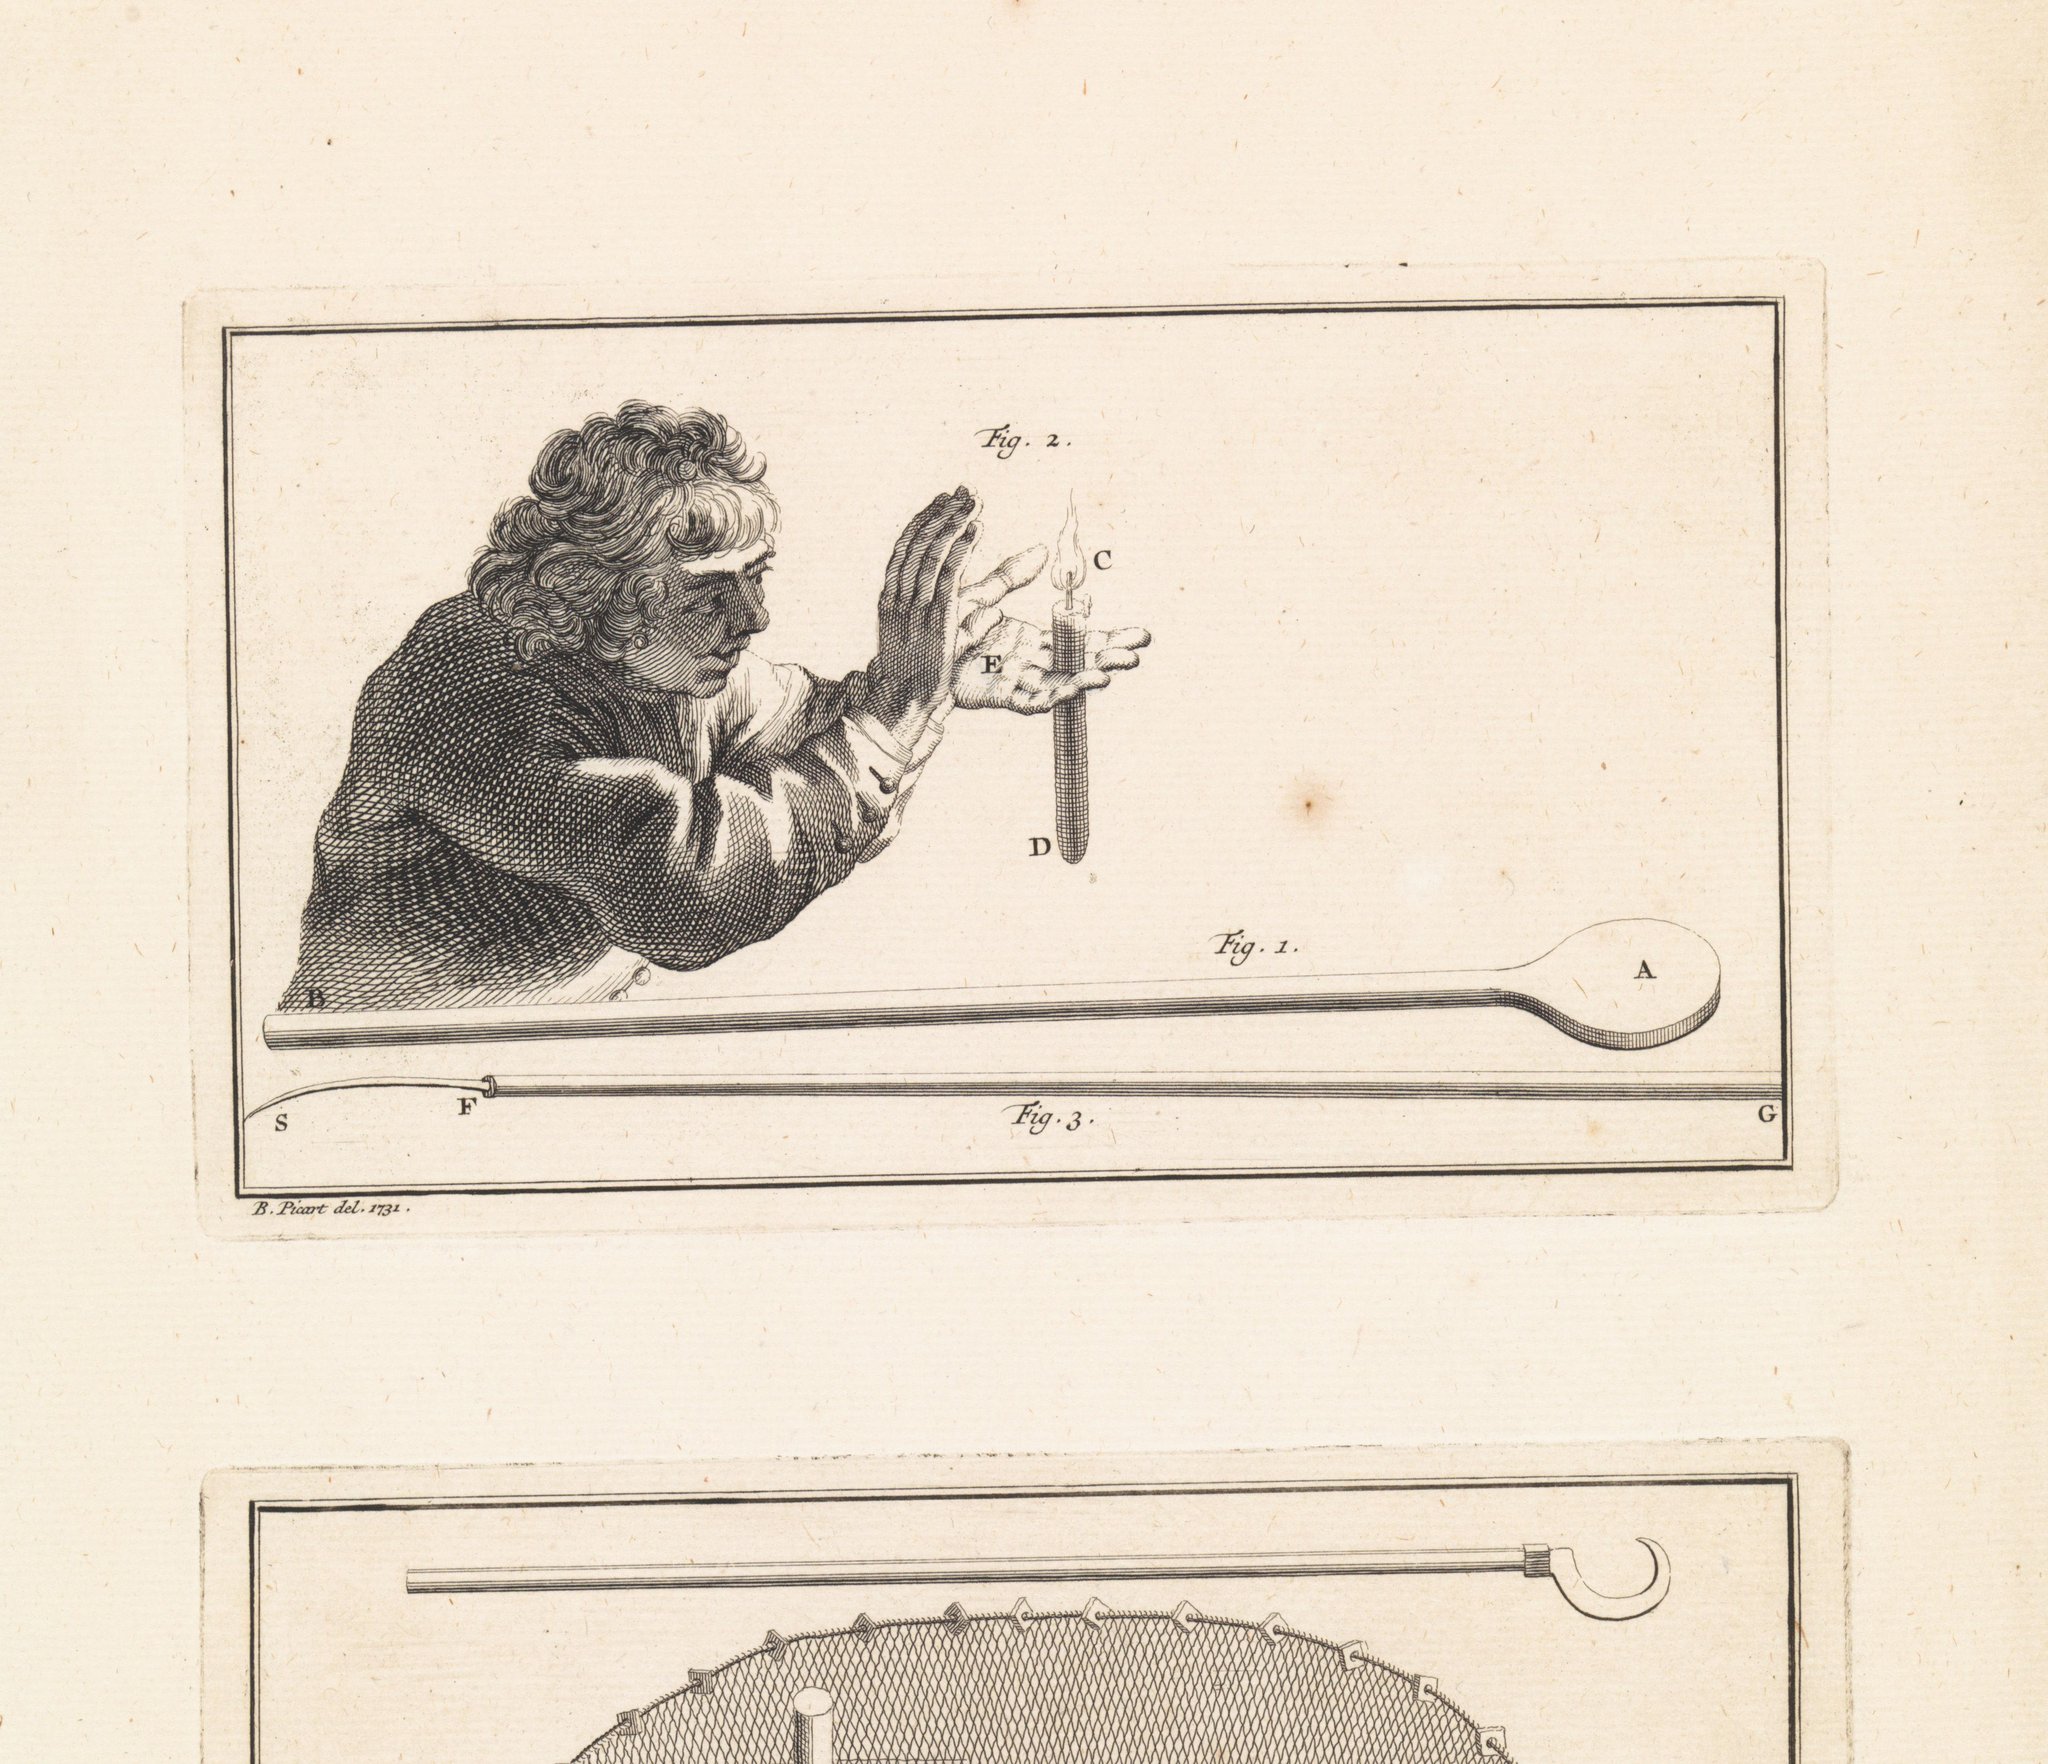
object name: book illustration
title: Man met een kaars en een constructie met een net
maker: bernard picart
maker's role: draughtsman, print maker, publisher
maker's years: 1673-1733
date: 1731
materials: paper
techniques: engraving, etching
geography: amsterdam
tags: fence, wall, paling, candlestick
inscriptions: collector's mark: Lugt 2233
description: Prenten bedoeld voor: Chomel, Noel. Dictionnaire oeconomique, contenant divers moïens d'augmenter son bien, et de conserver sa santé. Amsterdam: Johannes Covens en Cornelis Mortier, 1732.